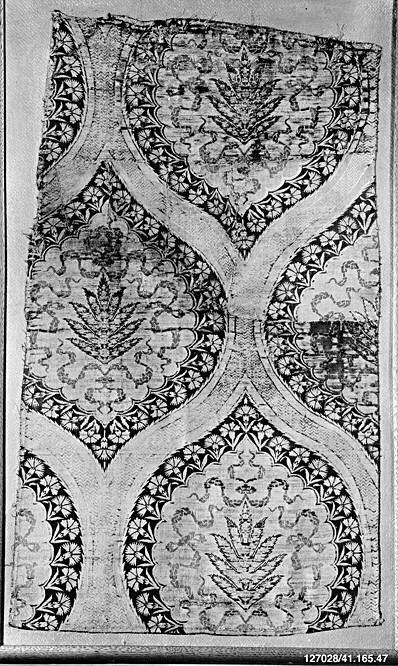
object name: panel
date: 1501-1600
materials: silk, silver, thread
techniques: weave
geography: turkey